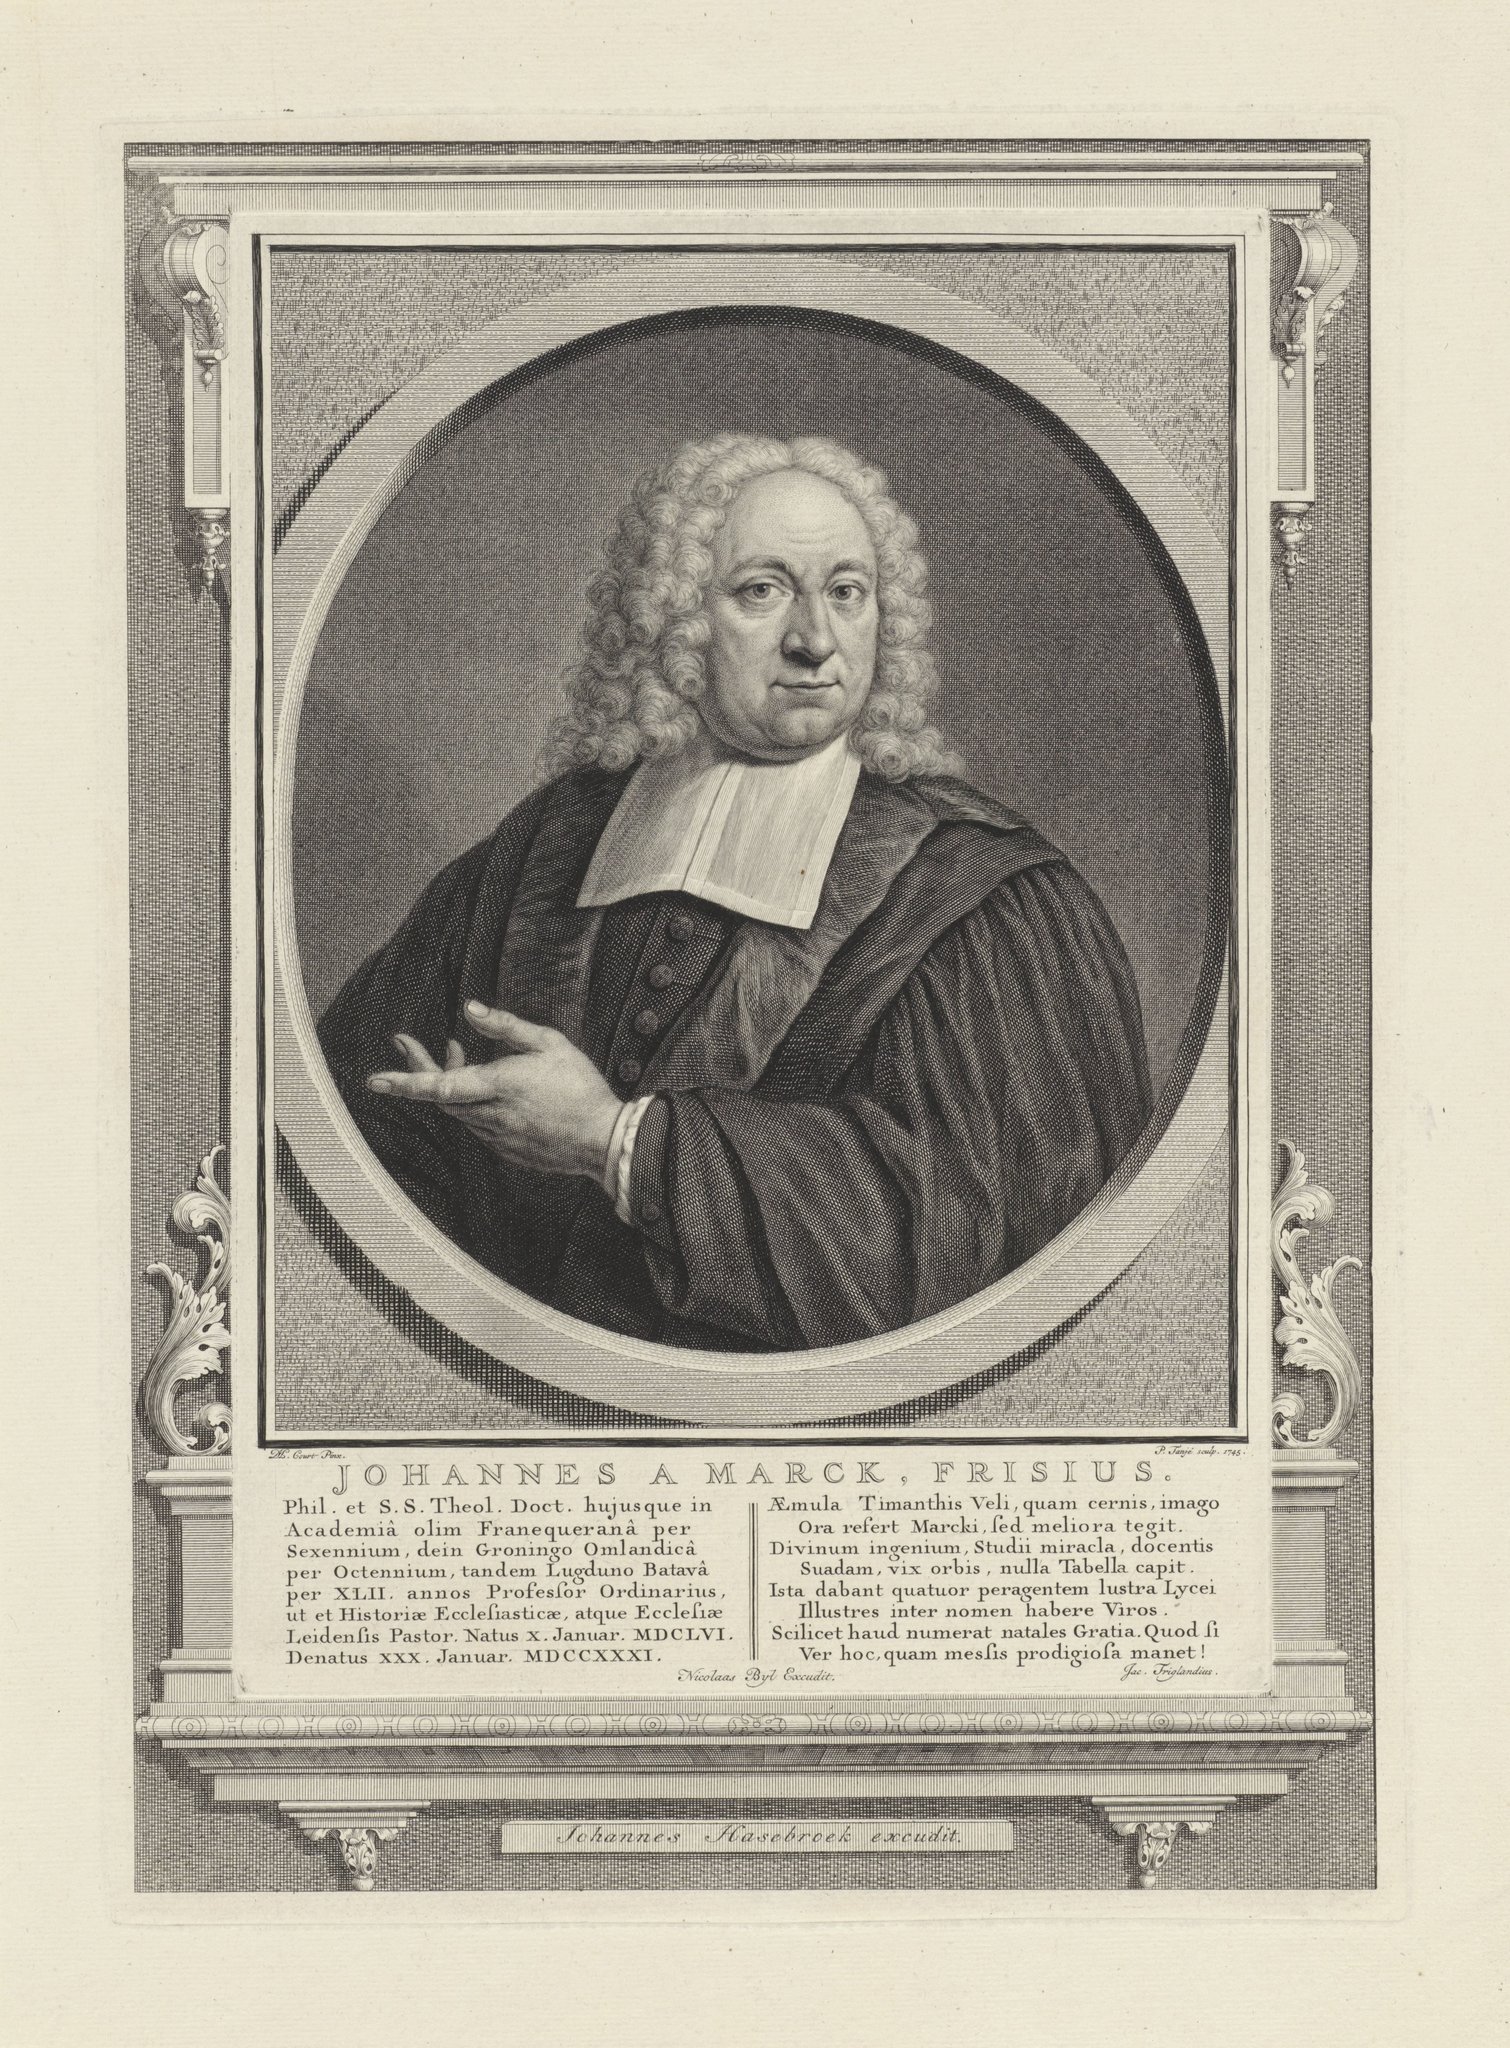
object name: print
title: Portret van Johannes à Marck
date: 1745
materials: paper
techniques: engraving, etching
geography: amsterdam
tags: leiden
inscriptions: collector's mark: Lugt 240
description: Predikant en hoogleraar in de theologie Johannes à Marck gekleed in toga met witte bef. Onderaan in de marge een tekst in het Latijn. Het geheel is gevat in een ornamentele randlijst.